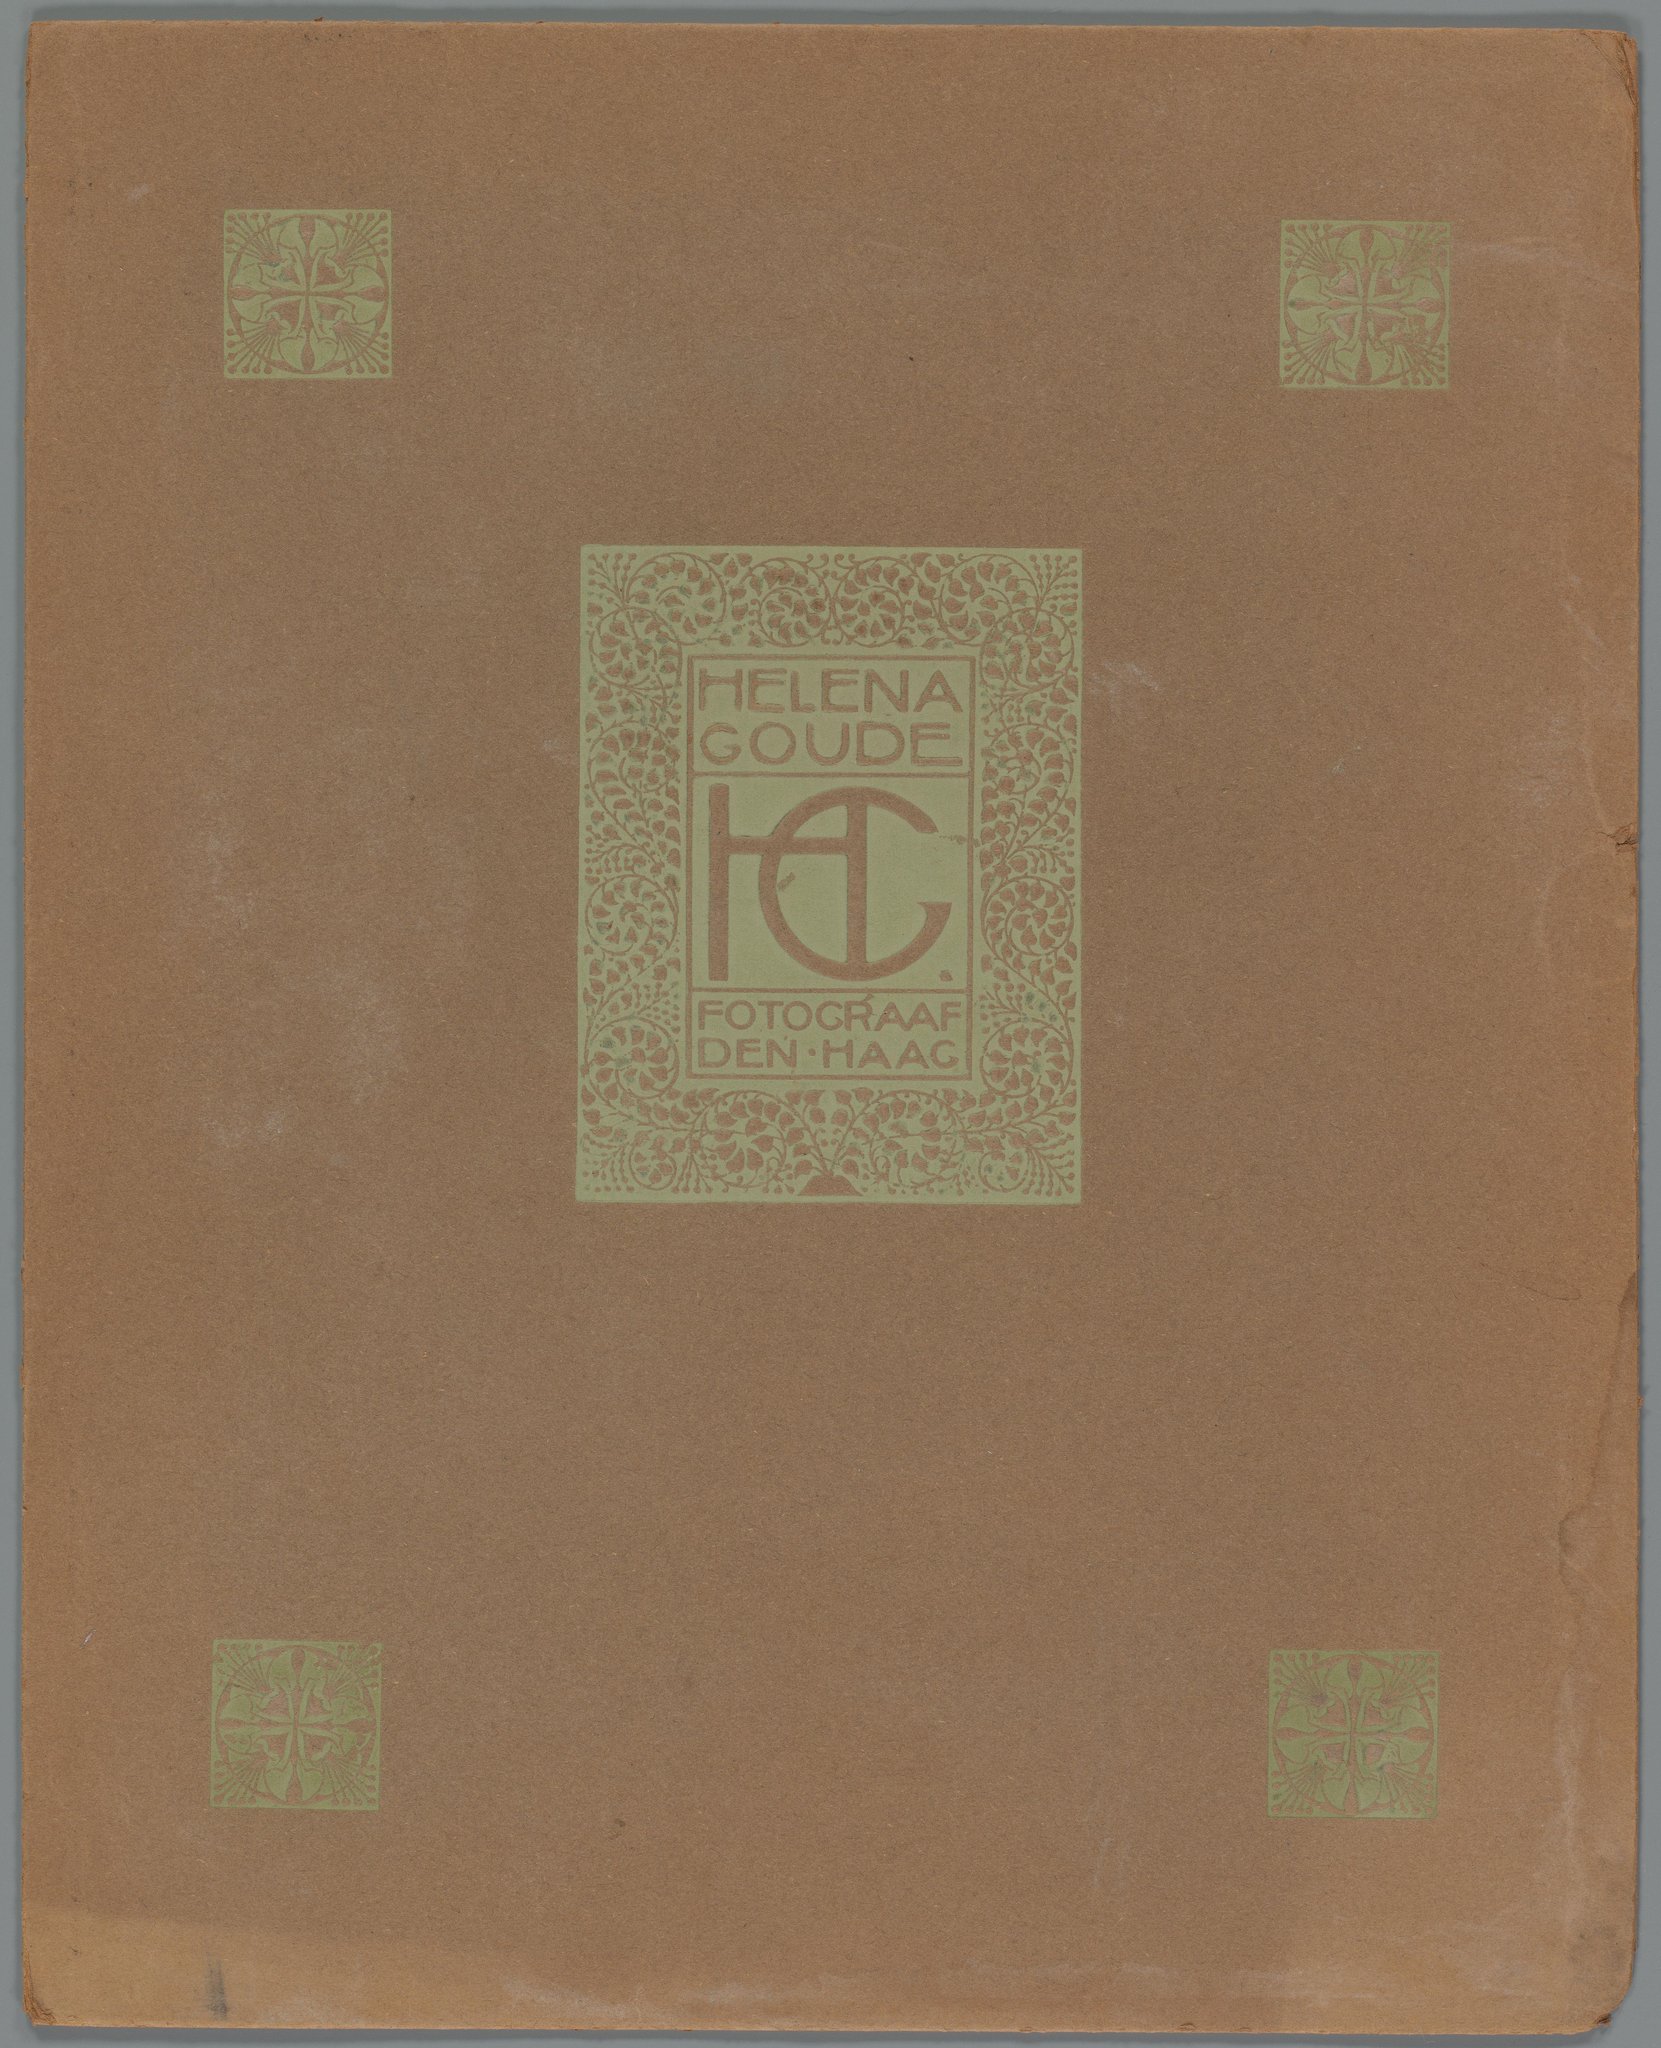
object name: envelope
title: Envelop voor Helena Goude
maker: Anonymous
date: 1900-1943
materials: paper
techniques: blind stamped, printing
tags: helena aleida goude, letter, envelope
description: Envelop voor fotograaf Helena Goude uit Den Haag. De envelop is versierd met ornamenten en haar initialen HC.